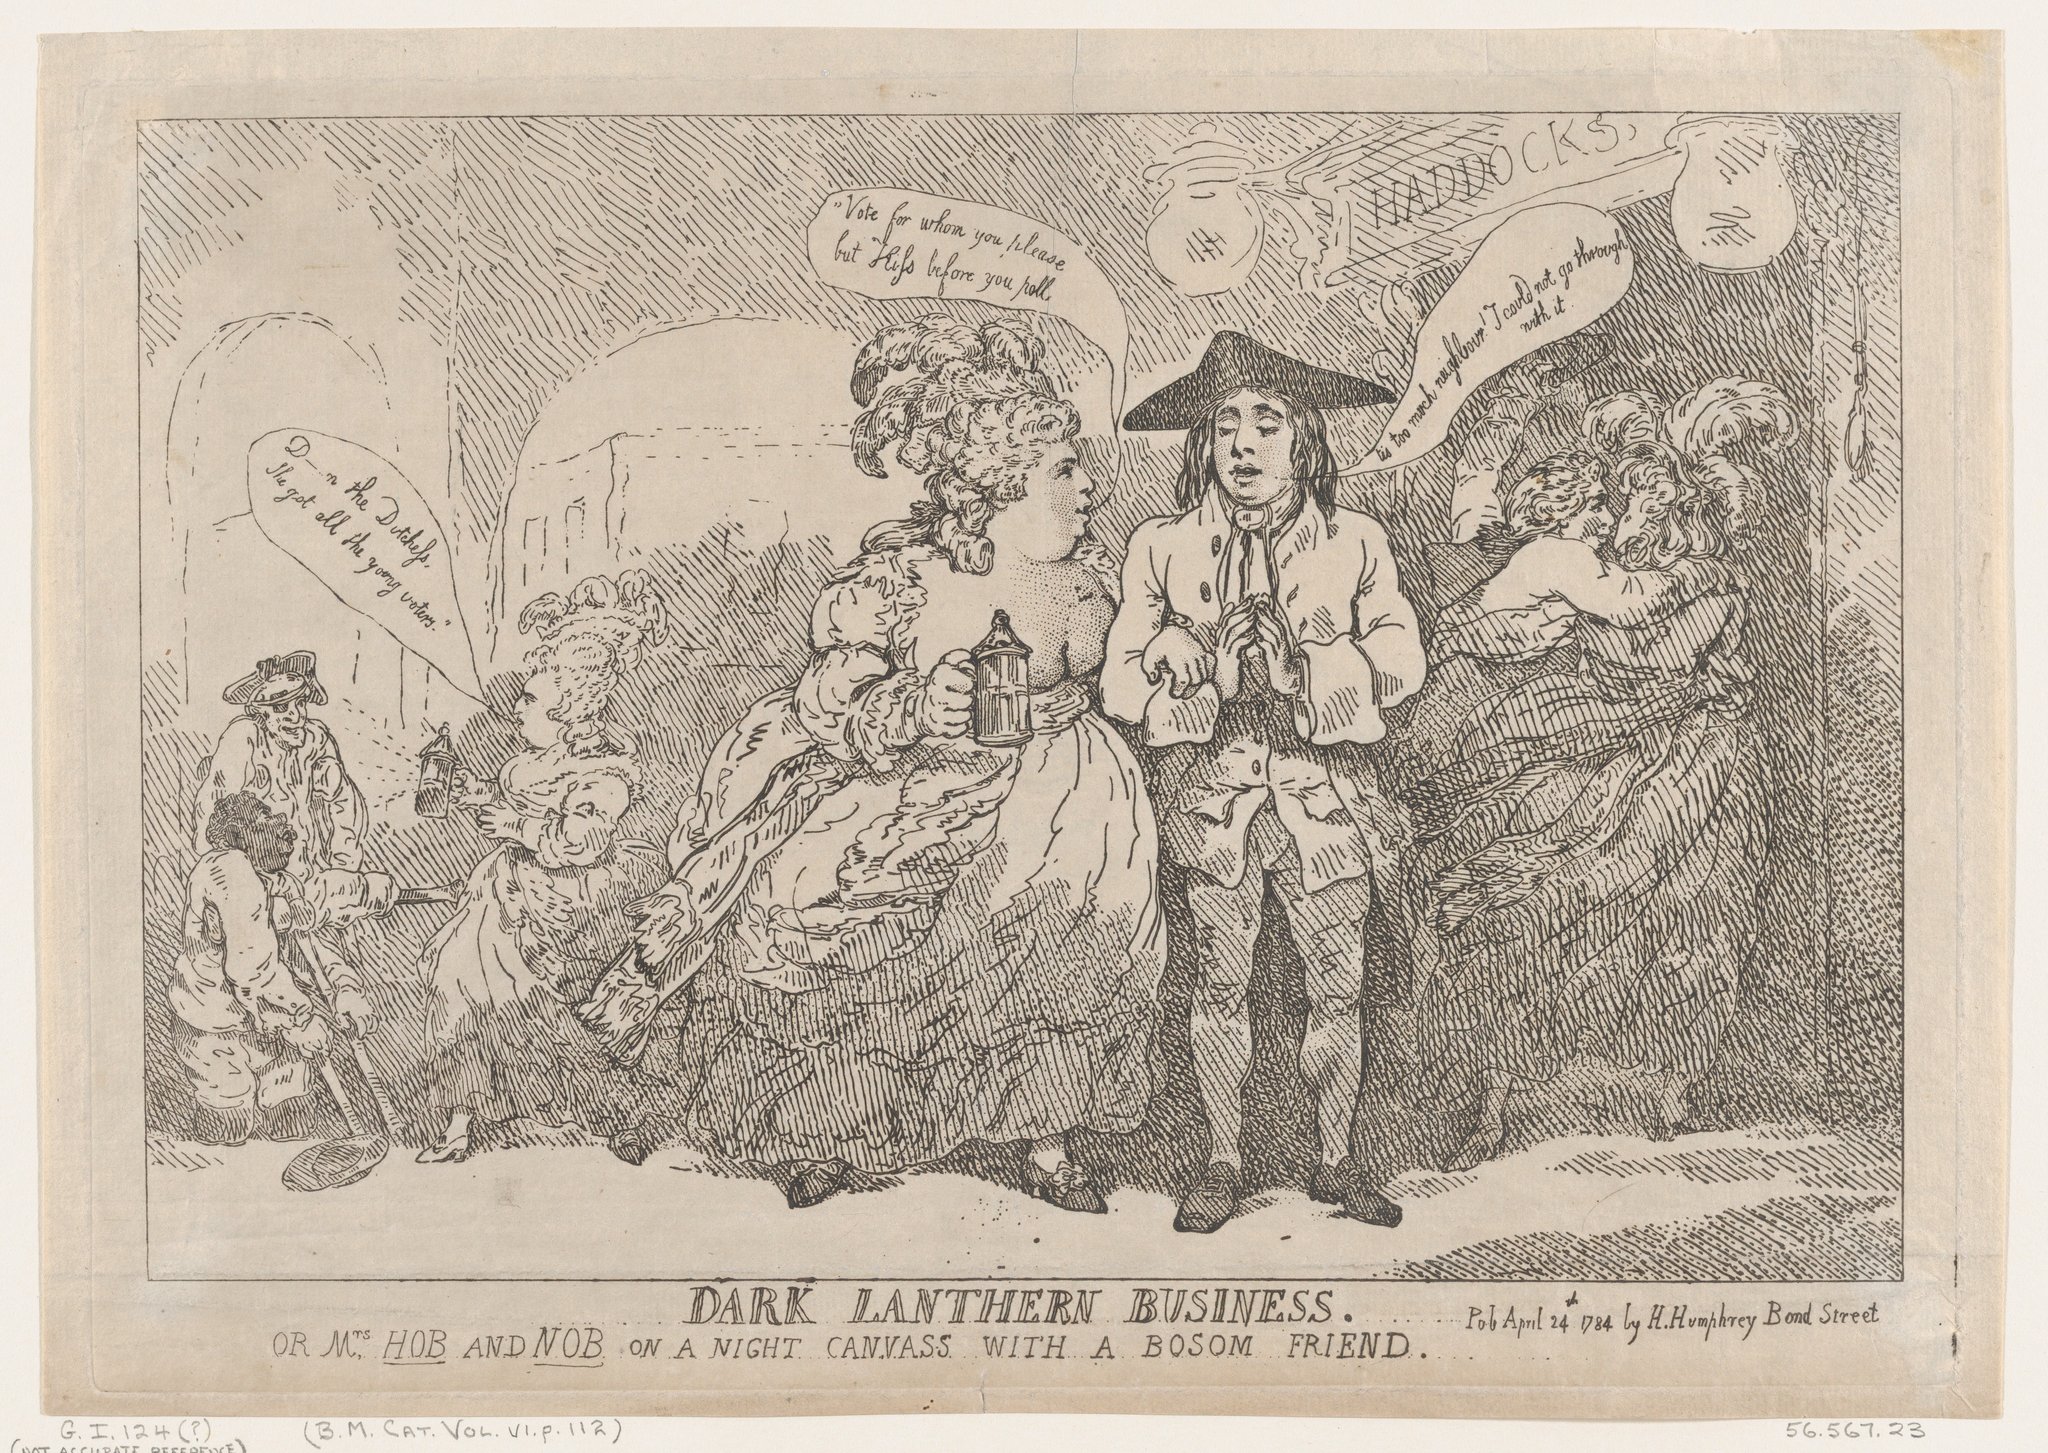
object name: print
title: Dark Lanthern Business, or, Mrs. Hob and Nob On a Night Canvass With a Bosom Friend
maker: thomas rowlandson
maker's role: artist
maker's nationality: british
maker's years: 1757-1827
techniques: etching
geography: london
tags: satire,men,women